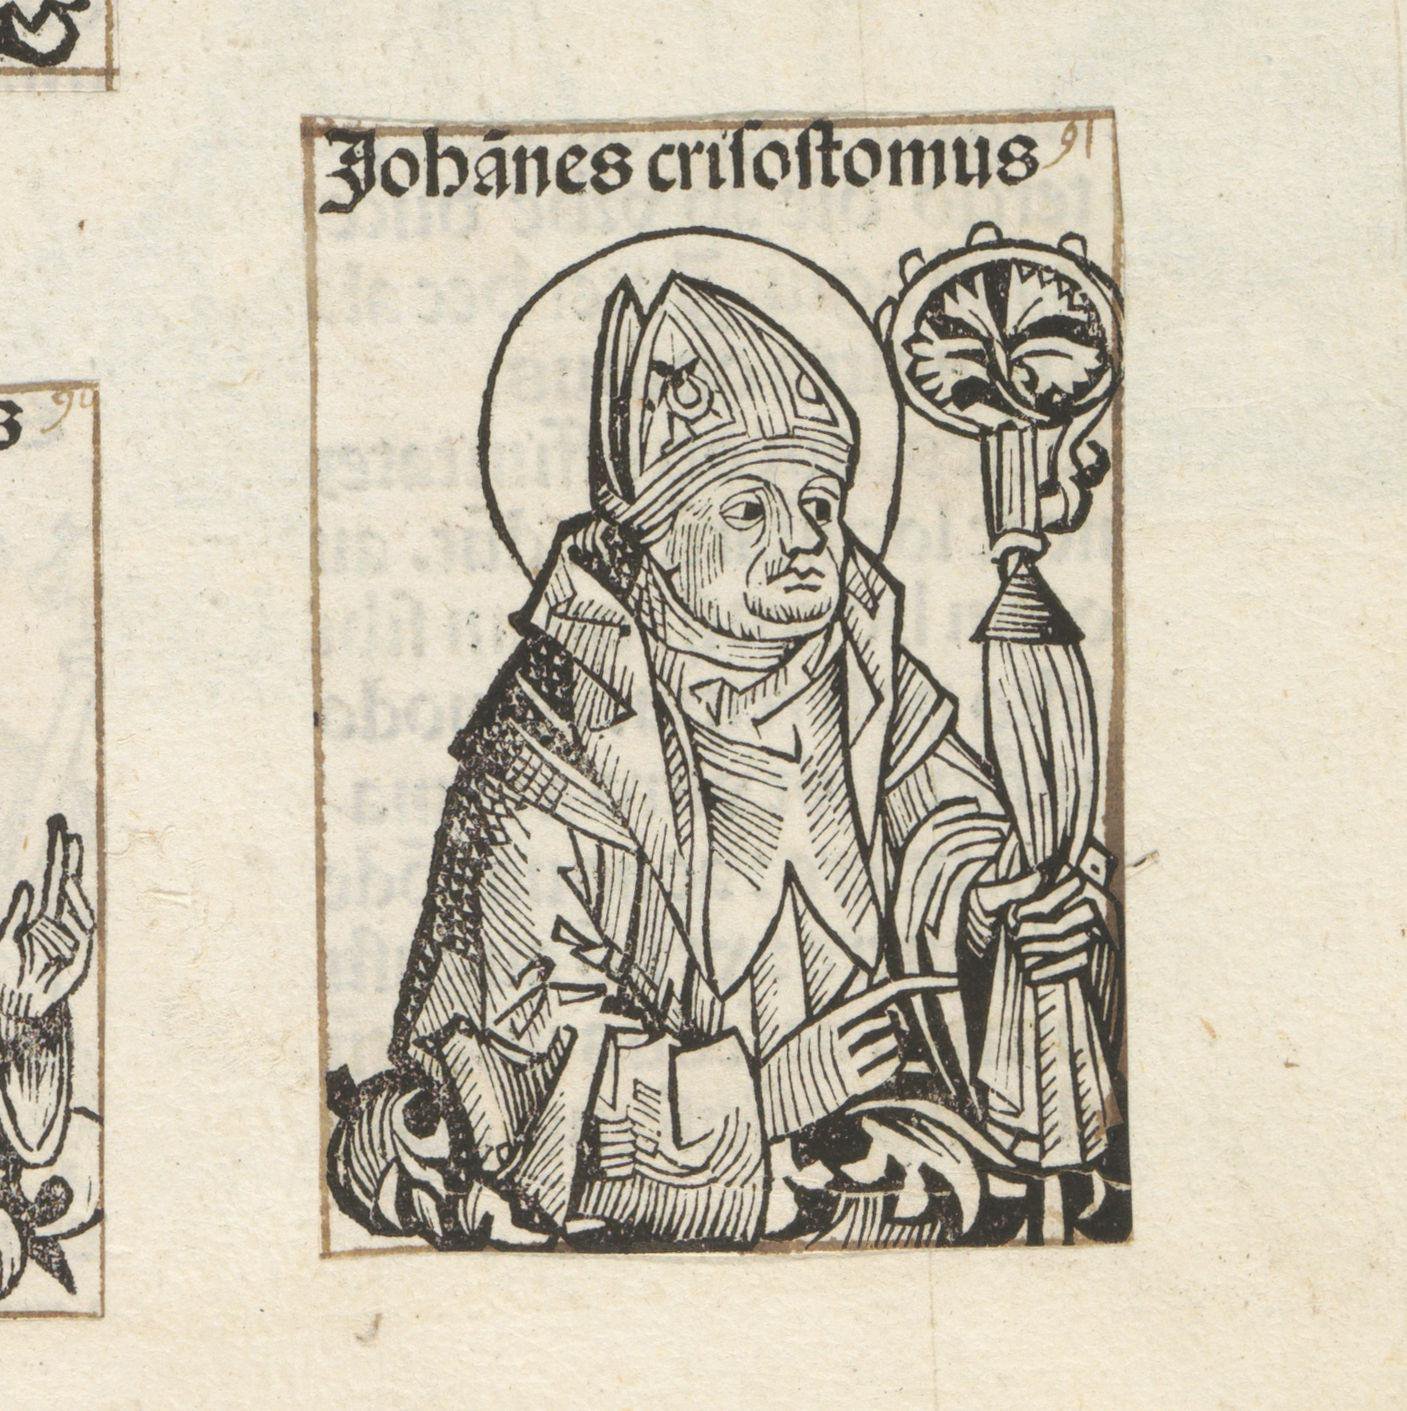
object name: album leaf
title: Johannes Chrysostomus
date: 1493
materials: paper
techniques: letterpress printing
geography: nuremberg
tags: male persons from classical history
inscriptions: inscription: ‘91’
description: De houtsnede wordt herhaaldelijk gebruikt als boekillustratie in de Liber Chronicarum (of Neurenbergkroniek) van Hartmann Schedel, verschenen in het Latijn en Duits in 1493. Zie de Latijnse uitgave, folio 135r.